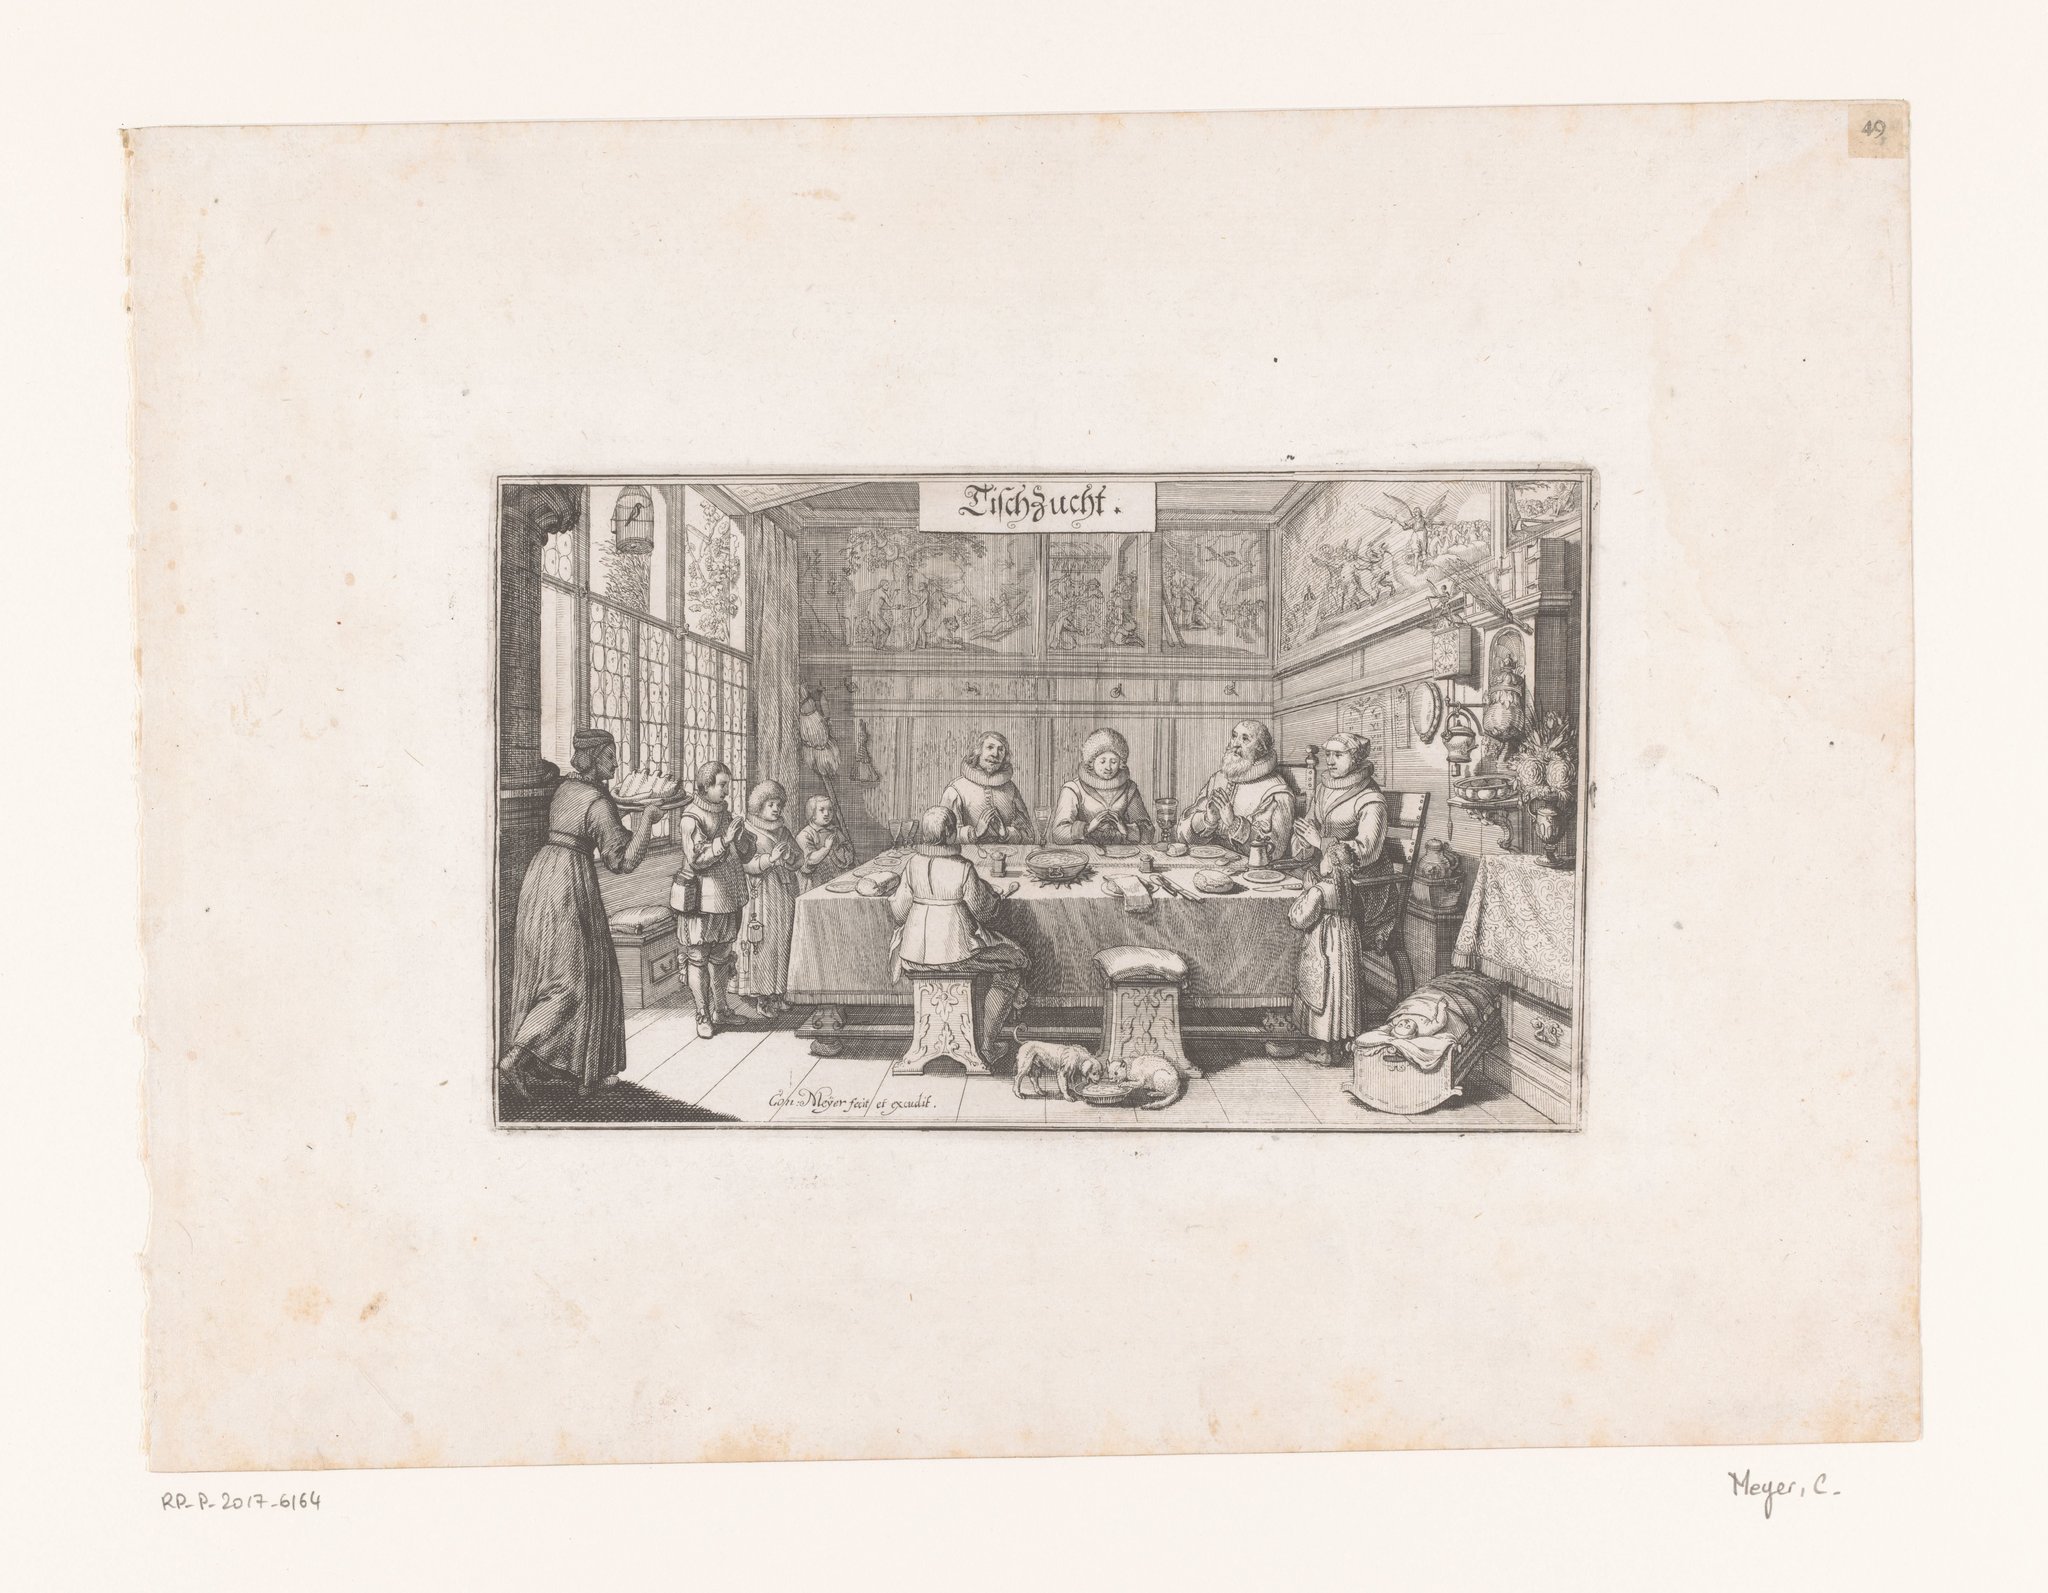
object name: print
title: Tischzucht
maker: conrad meyer (i)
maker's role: painter, print maker, publisher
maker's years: 1618-1689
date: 1645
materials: paper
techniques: etching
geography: zurich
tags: parents with their children, picture within picture, clock, family life at home, prayer at table, saying grace, dining-room, (family) meal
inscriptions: collector's mark: Lugt 2228, collector's mark: Lugt 2760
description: De familie van Dietrich Meyer (vader en leraar van de kunstenaar) in gebed aan tafel. Drie kinderen staan links van de tafel, rechts een kind in een wieg. Links gebrandschilderde ramen, aan de muren voorstellingen met bijbelse scènes. Rechts een uurwerk en een takkenbos (gesel).